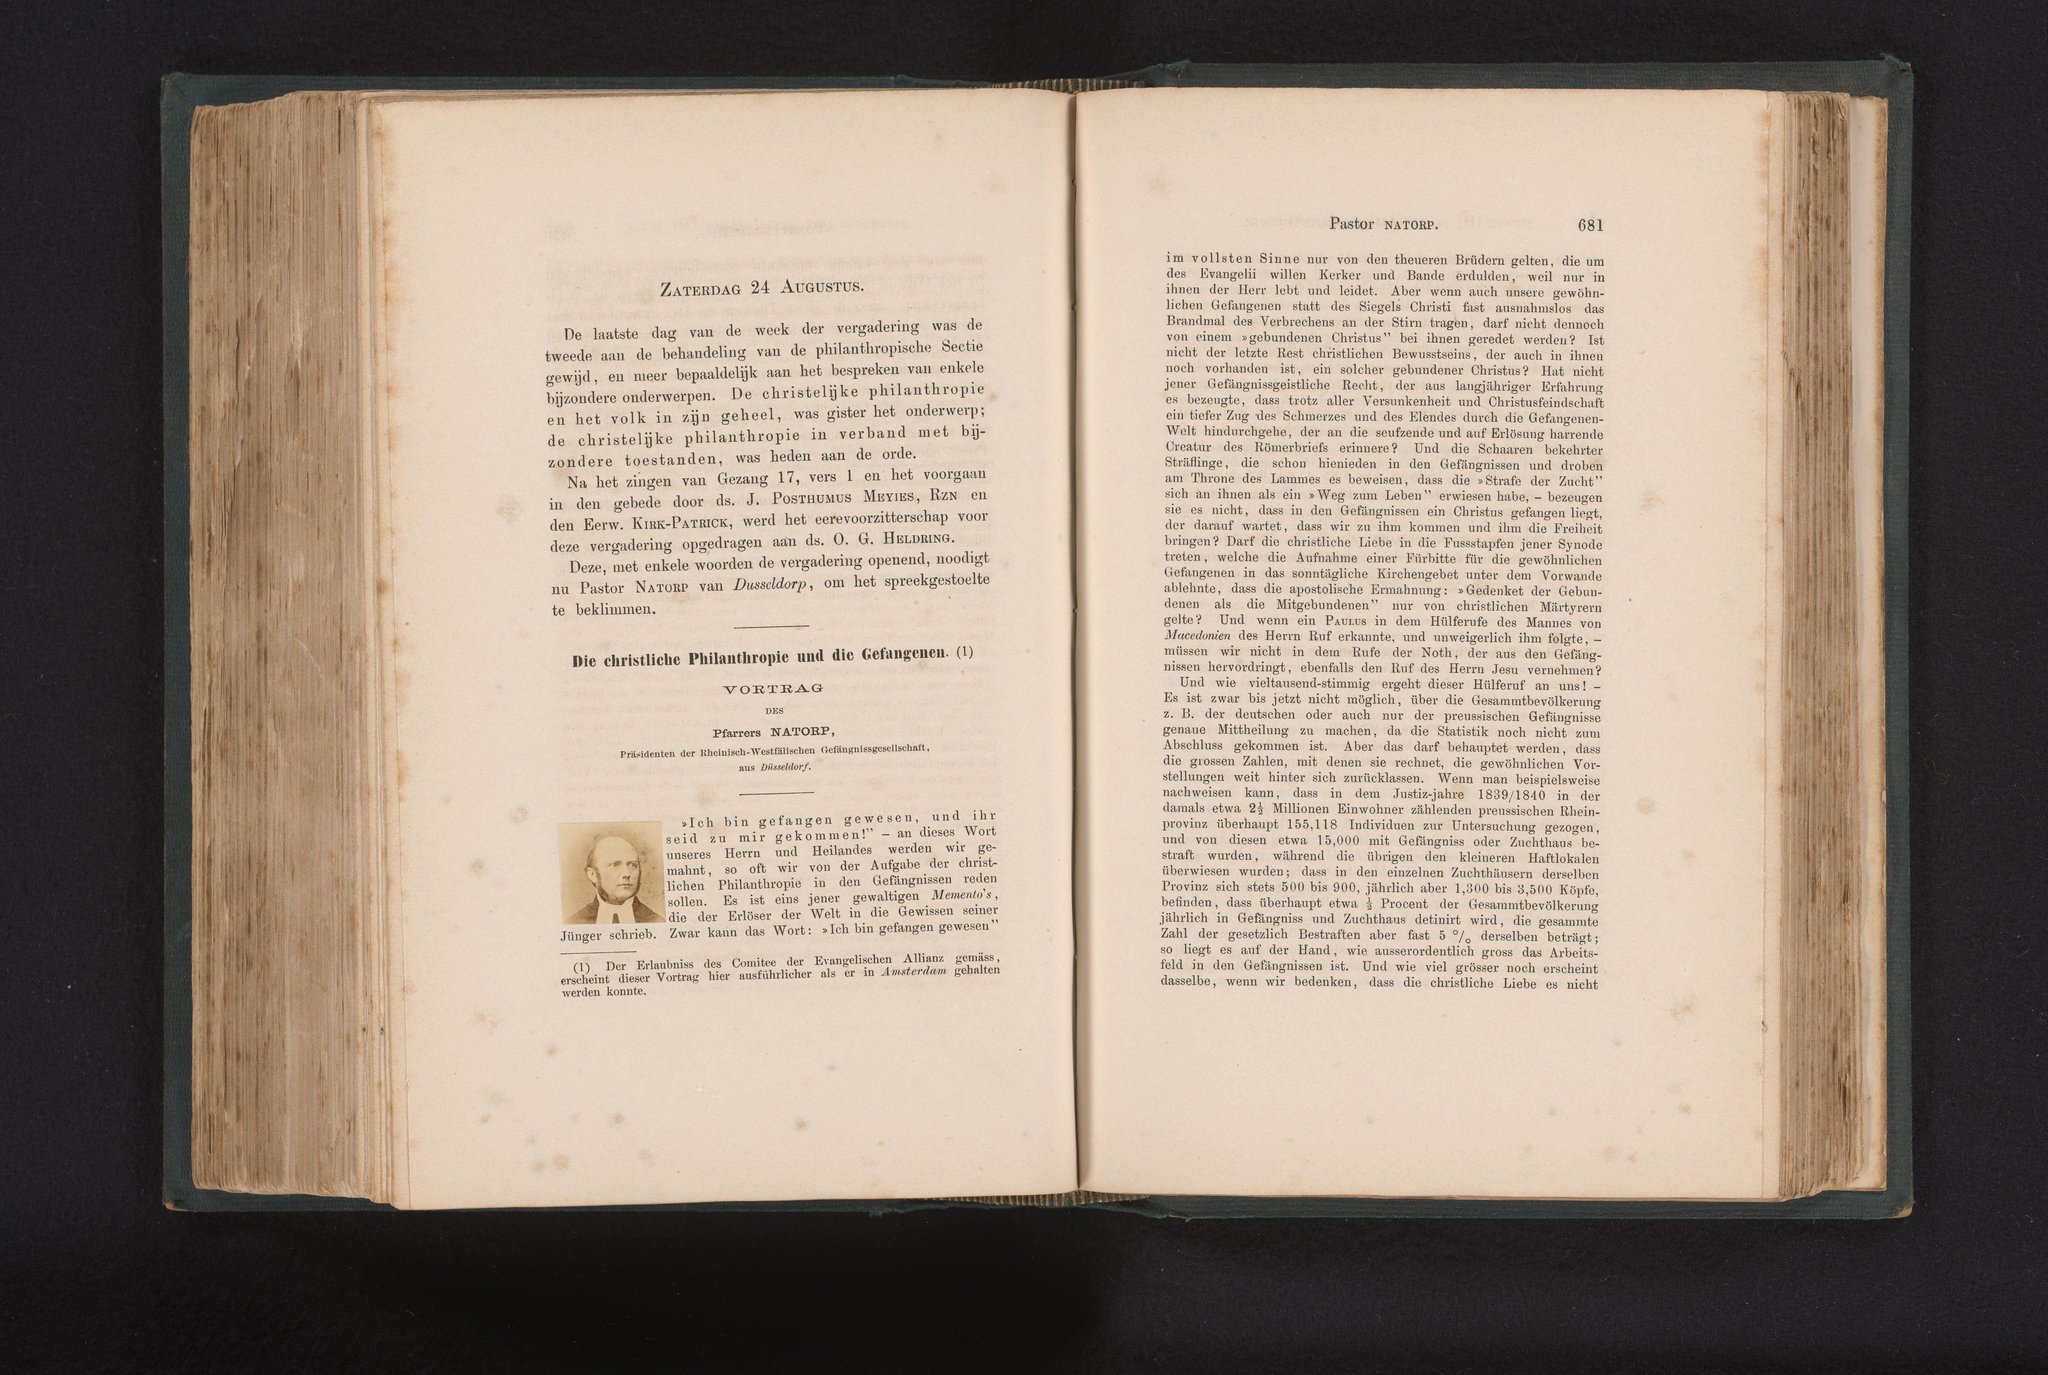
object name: page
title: Portret van pastoor Gottfried Natorp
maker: Anonymous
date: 1855-1867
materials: paper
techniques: albumen print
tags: adult man, historical persons